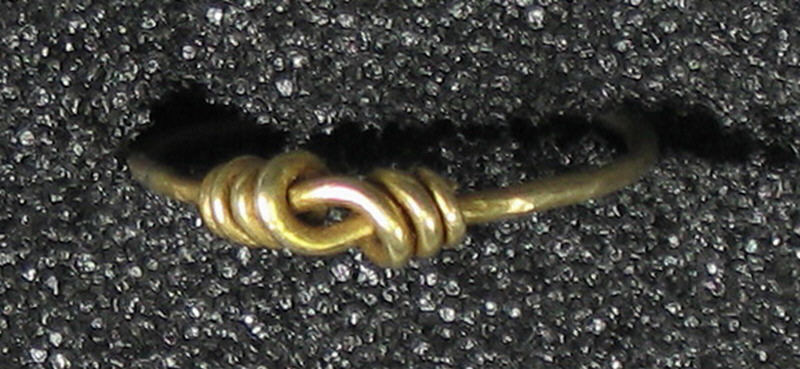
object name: ring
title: Ring with Twisted Wire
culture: indonesian, central java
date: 701-1200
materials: gold